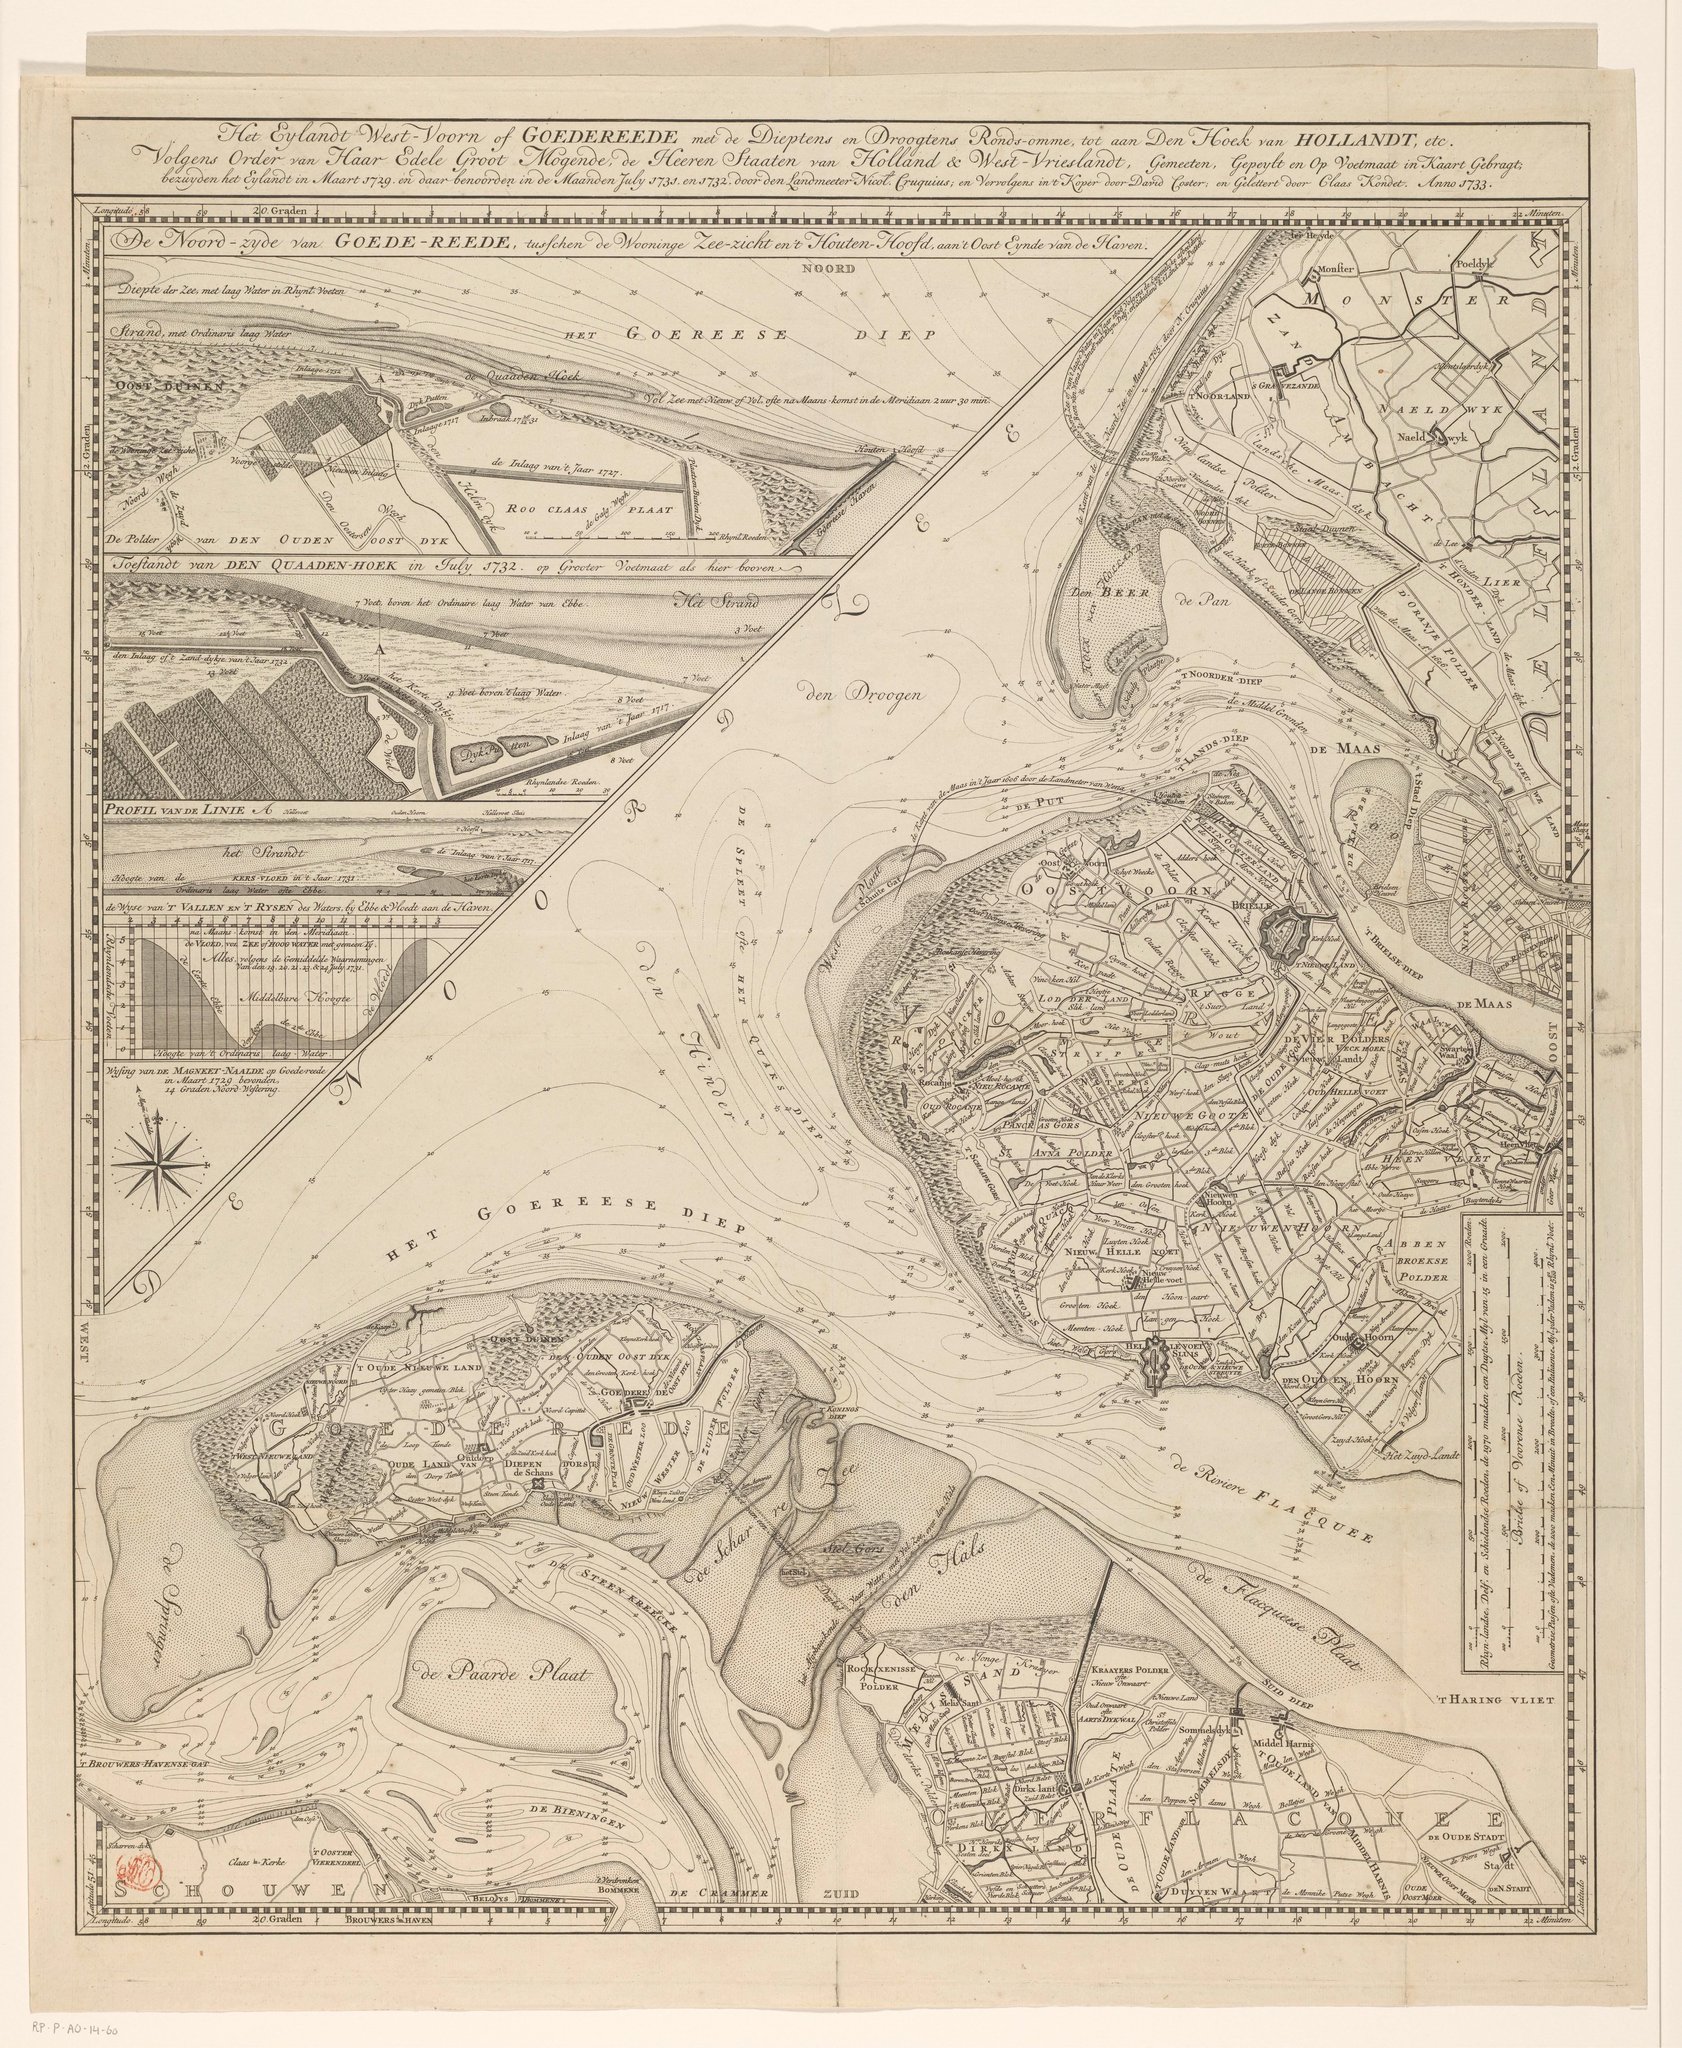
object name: map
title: Het eylandt West-Voorn of Goedereede met de dieptens en droogtens ronds-omme, tot aan Den Hoek van Hollandt, etc. (…)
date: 1733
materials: paper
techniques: engraving, etching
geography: the hague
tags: maps of separate countries or regions, dikes, levee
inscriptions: collector's mark: Lugt 195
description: Hoort bij een resolutie van 23 juli 1734, zie documentatie voor meer informatie. Zie ook RP-P-AO-14-31.